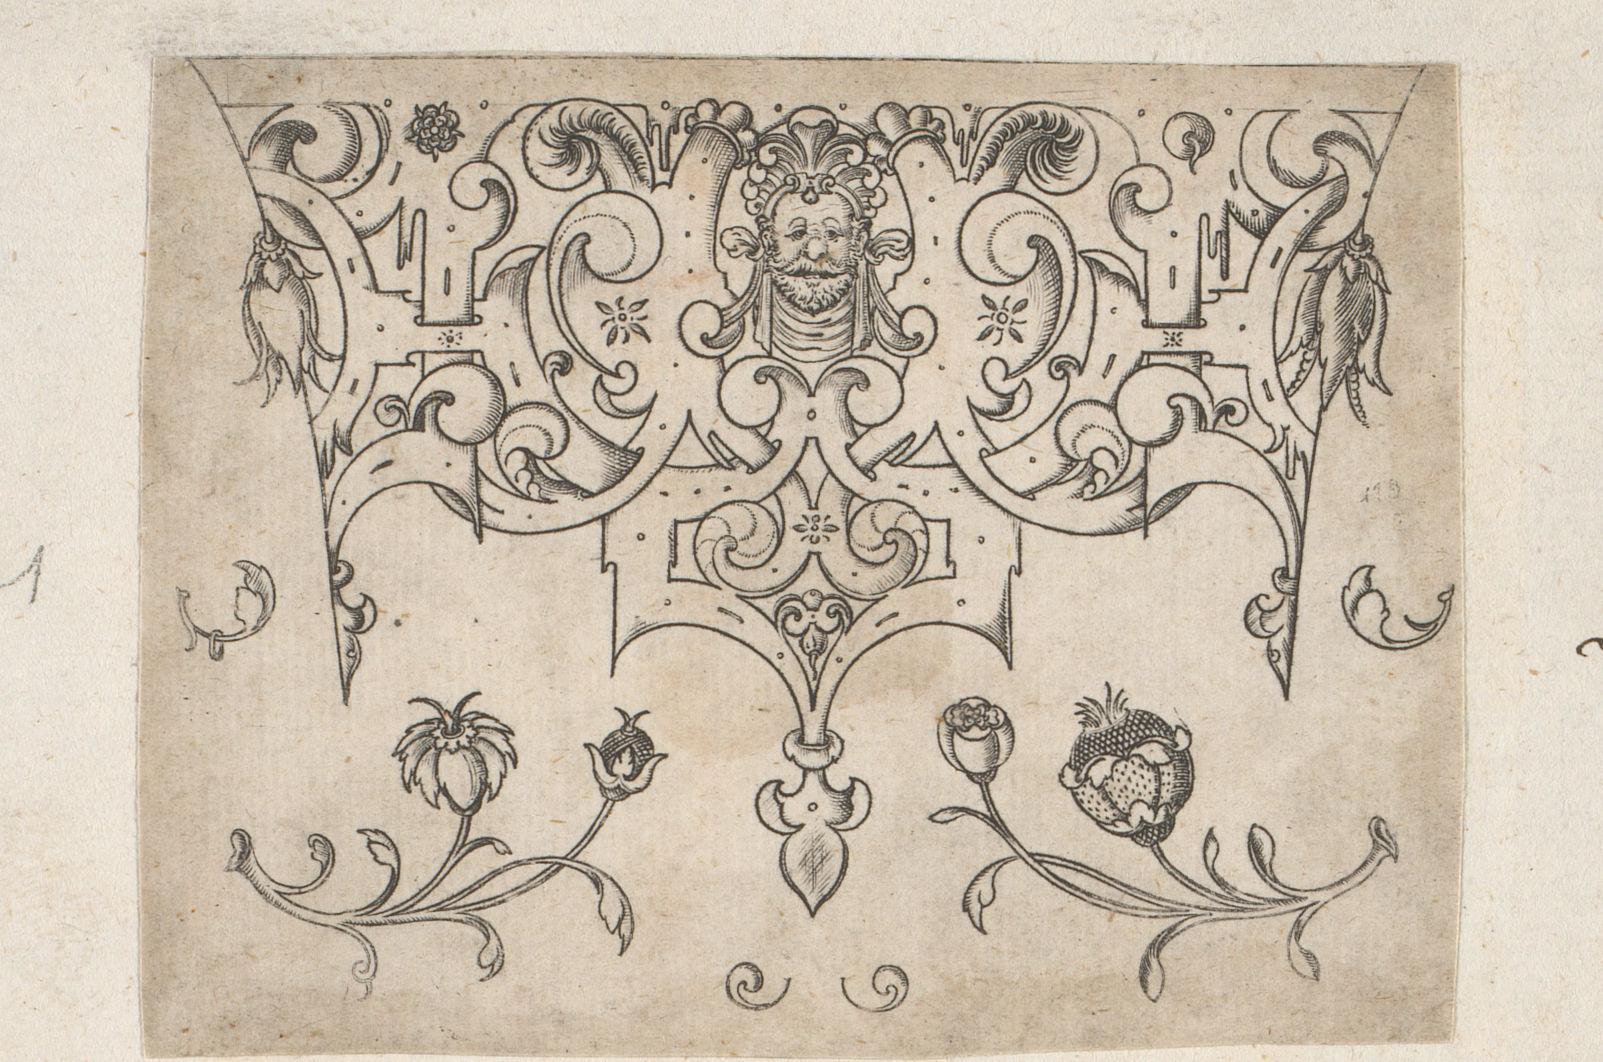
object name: ornament print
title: Ontwerp voor een ornament met bloemen en masker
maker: Anonymous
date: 1550-1650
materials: paper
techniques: engraving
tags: ornament derived from plant forms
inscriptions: collector's mark: Lugt 2760, collector's mark: Lugt 2228